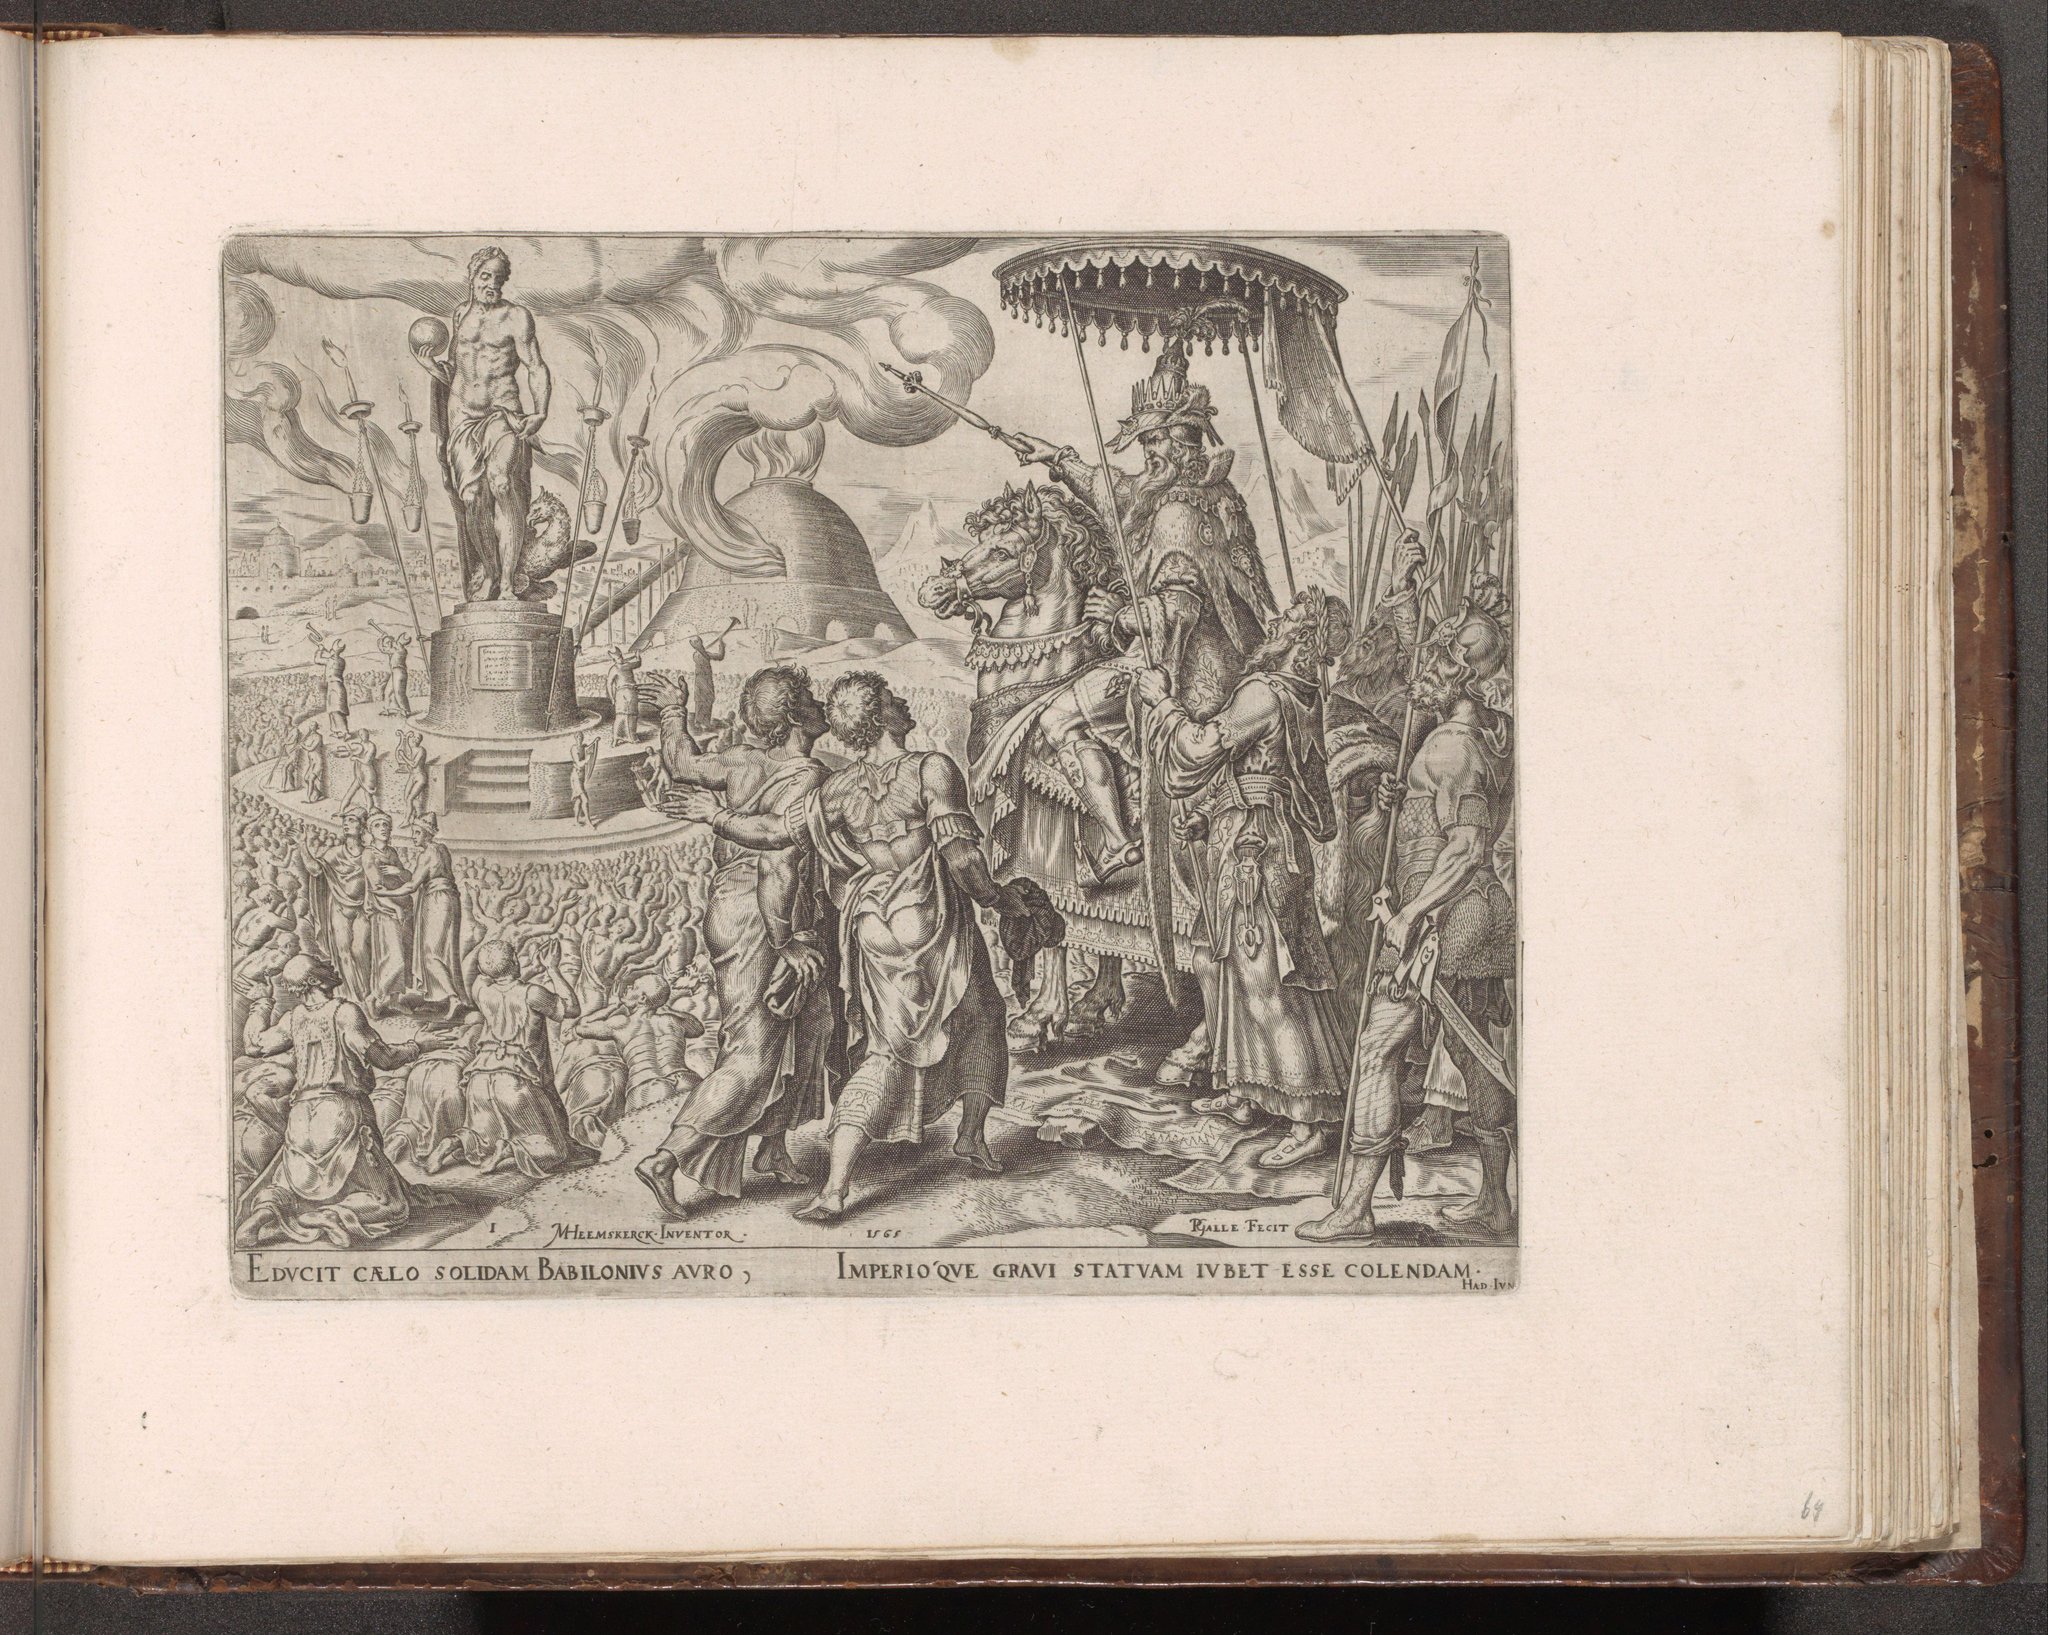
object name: album leaf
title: Thesaurus sacrarum historiaru[m] veteris testame[n]ti, elega[n]tissimis imaginibus expressu[m] excelle[n]tissimoru[m] in hac arte viroru[m] opera: nu[n]c primu[m] in luce[m] editus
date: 1565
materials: paper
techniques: engraving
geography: antwerp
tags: it is reported to king nebuchadnezzar that shadrach, mesach, and abed-nego do not worship the golden statue, the dedication of the golden statue: in the presence of king nebuchadnezzar, trumpets are blown and all the people surrounding the image fall on their knees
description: Twee mannen rapporteren aan Koning Nebukadnessar dat Sadrach, Mesach en Abednego niet willen buigen voor het gouden beeld dat de koning heeft laten oprichten. Links het gouden standbeeld en een mensenmassa die het beeld aanbidt. Sadrach, Mesach en Abednego blijven staan. Op de achtergrond een brandende oven, waarin iedereen die weigert het beeld te aanbidden zal worden gegooid. Onder de voorstelling een verklarende tekst in het Latijn. Prent maakt deel uit van een album.